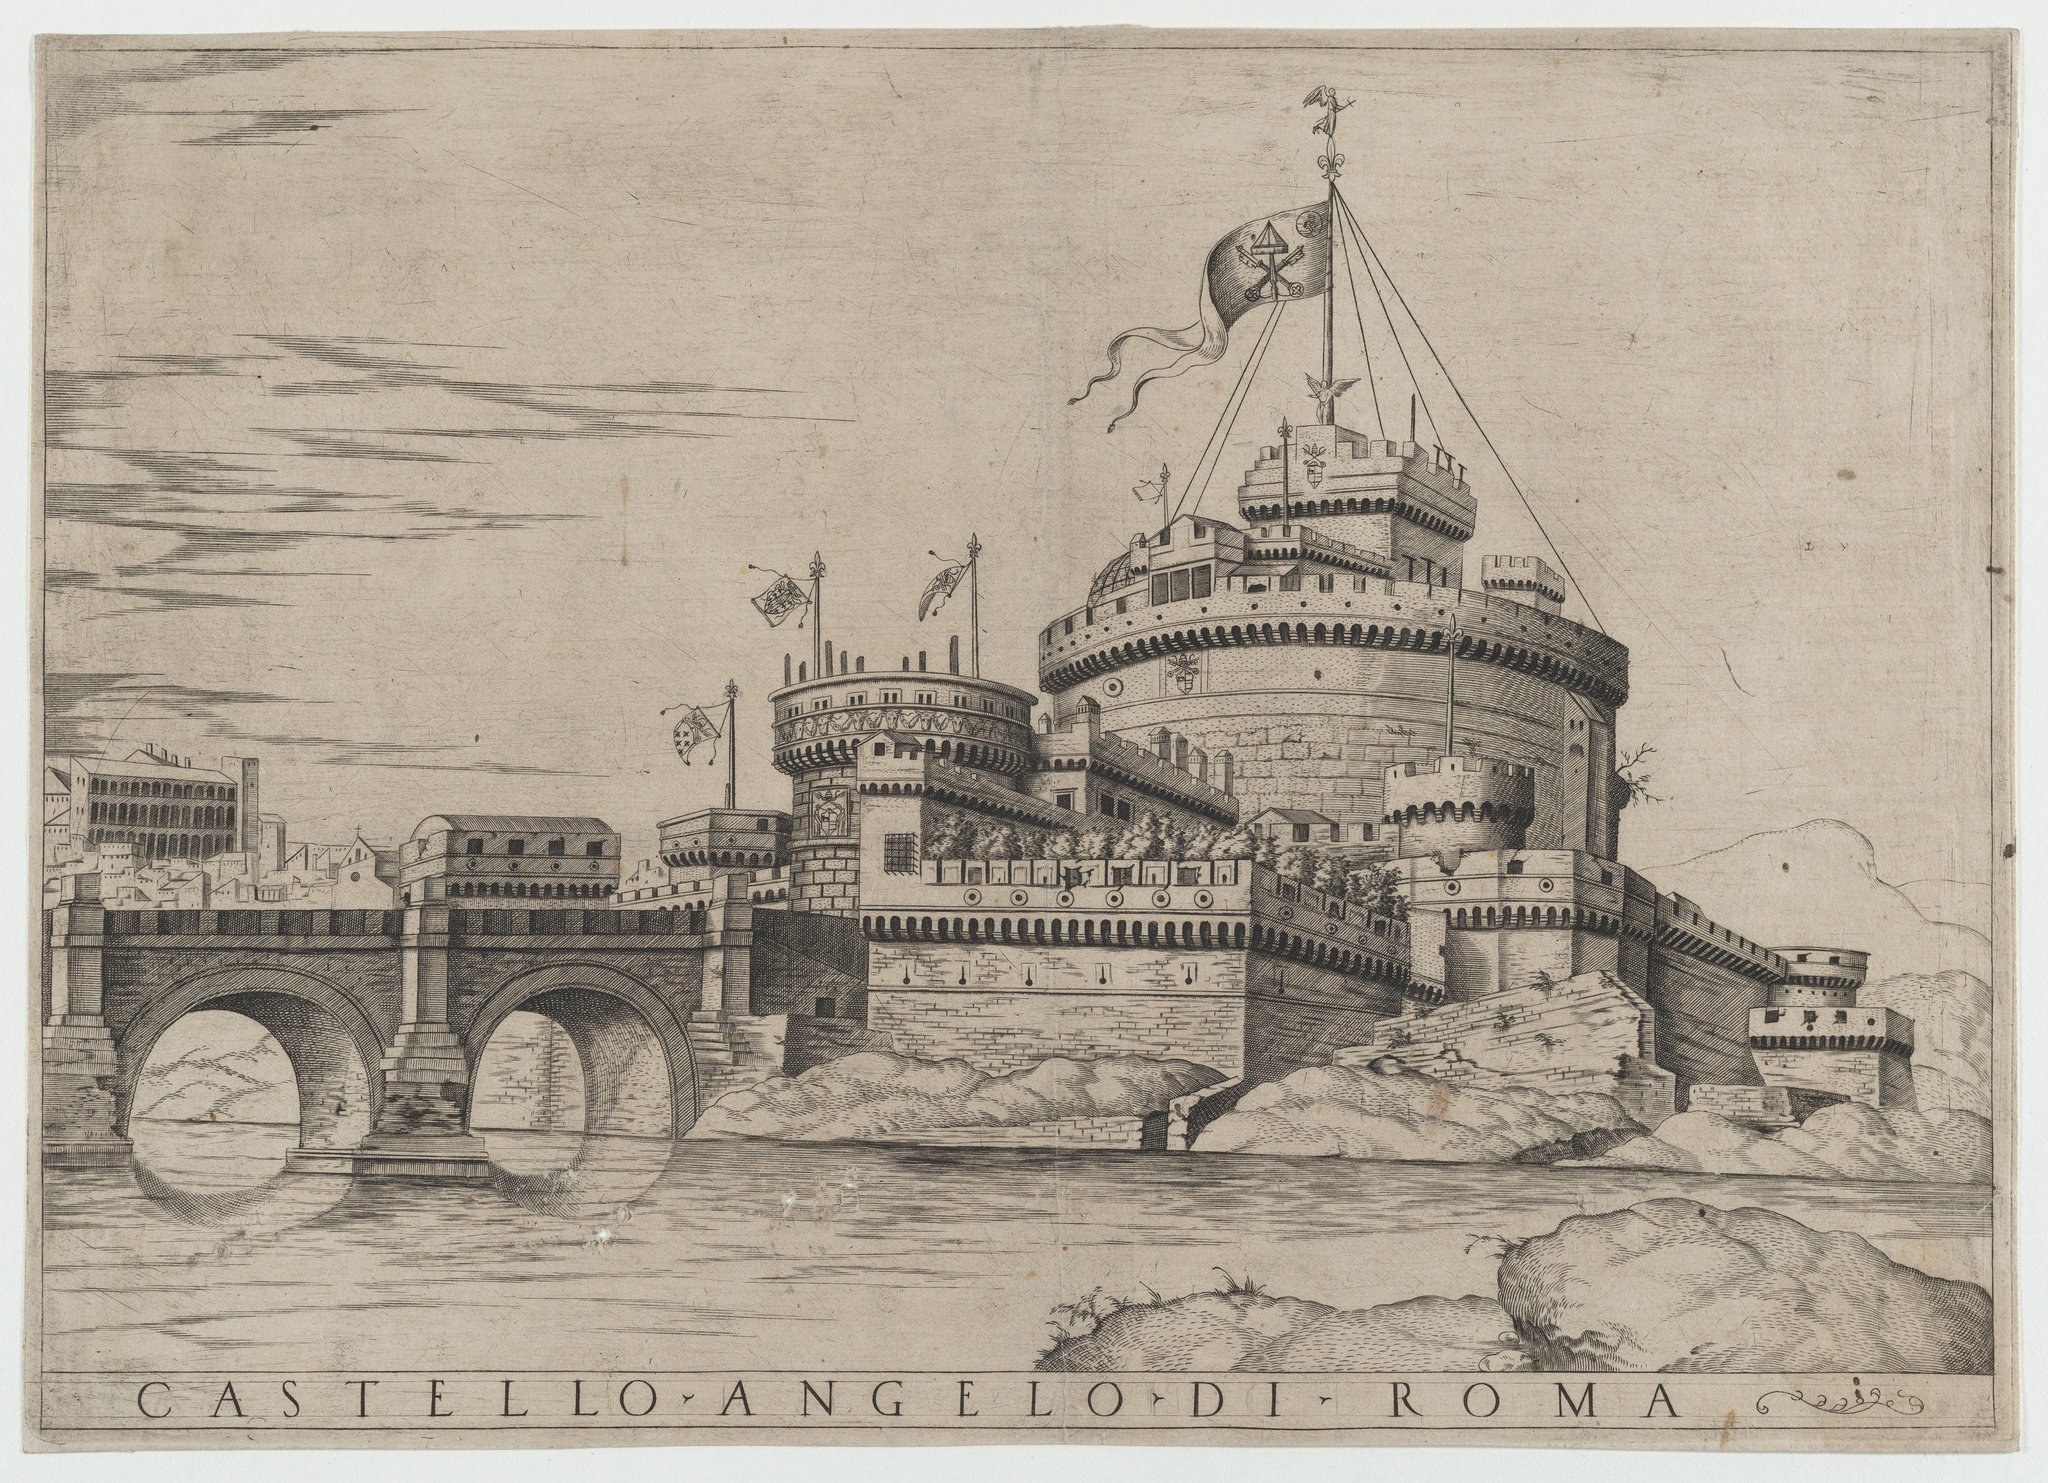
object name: print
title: Castello San Angelo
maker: Anonymous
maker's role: artist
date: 1501-1600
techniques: engraving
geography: rome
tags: castles,bridges,rome